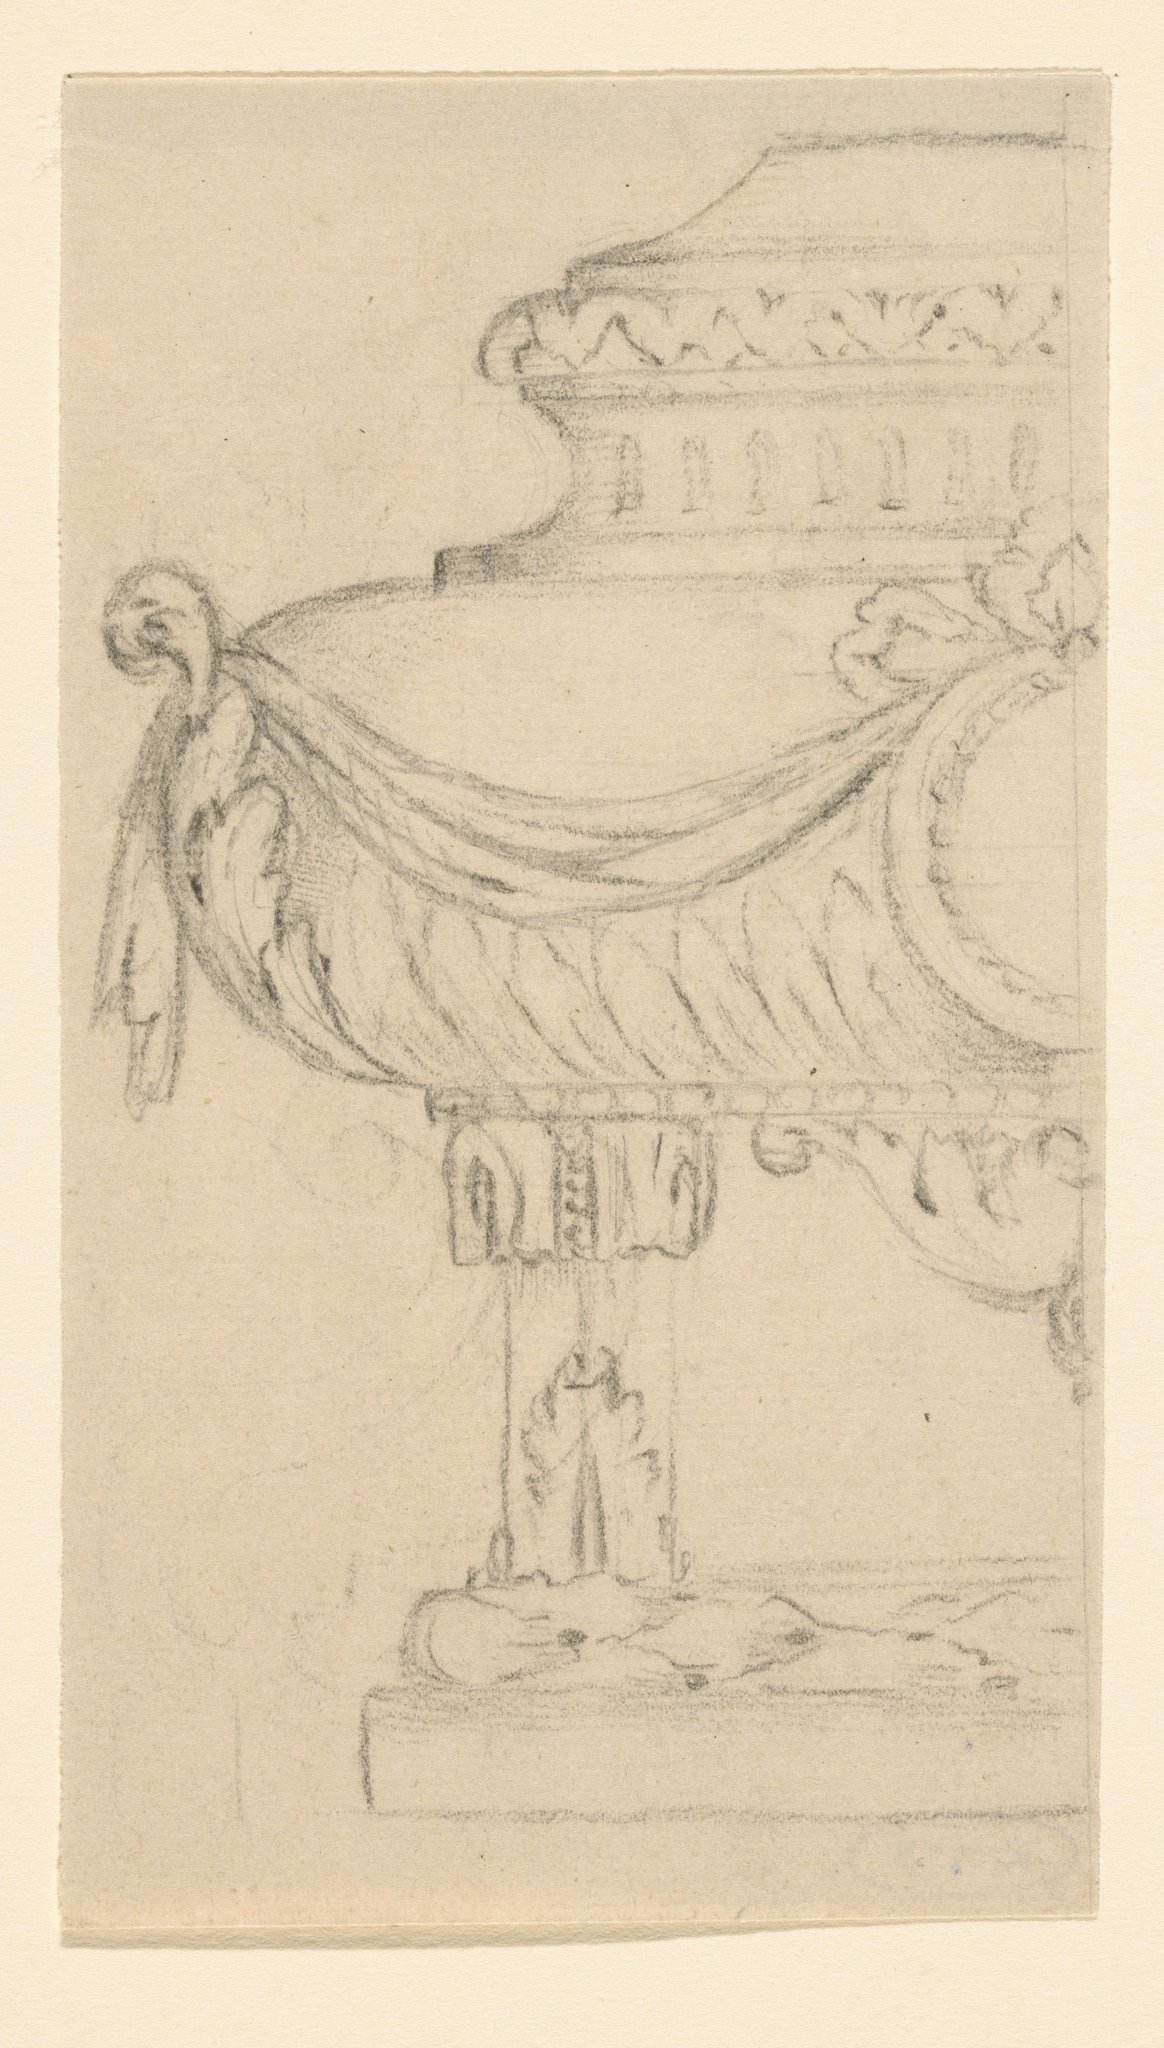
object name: drawing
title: Grafmonument met cherubijnen en kruis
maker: Anonymous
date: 1650-1800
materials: ink, paper, pencil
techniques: brush, pen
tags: cherubs, i.e. children's heads with wings, the cross ~ symbols of christ, grave, tomb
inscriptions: collector's mark: Lugt 2228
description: Een grafmonument met cherubijnen en aan de bovenzijde een kruis met Christusmedaillon, speer en azijnspons.